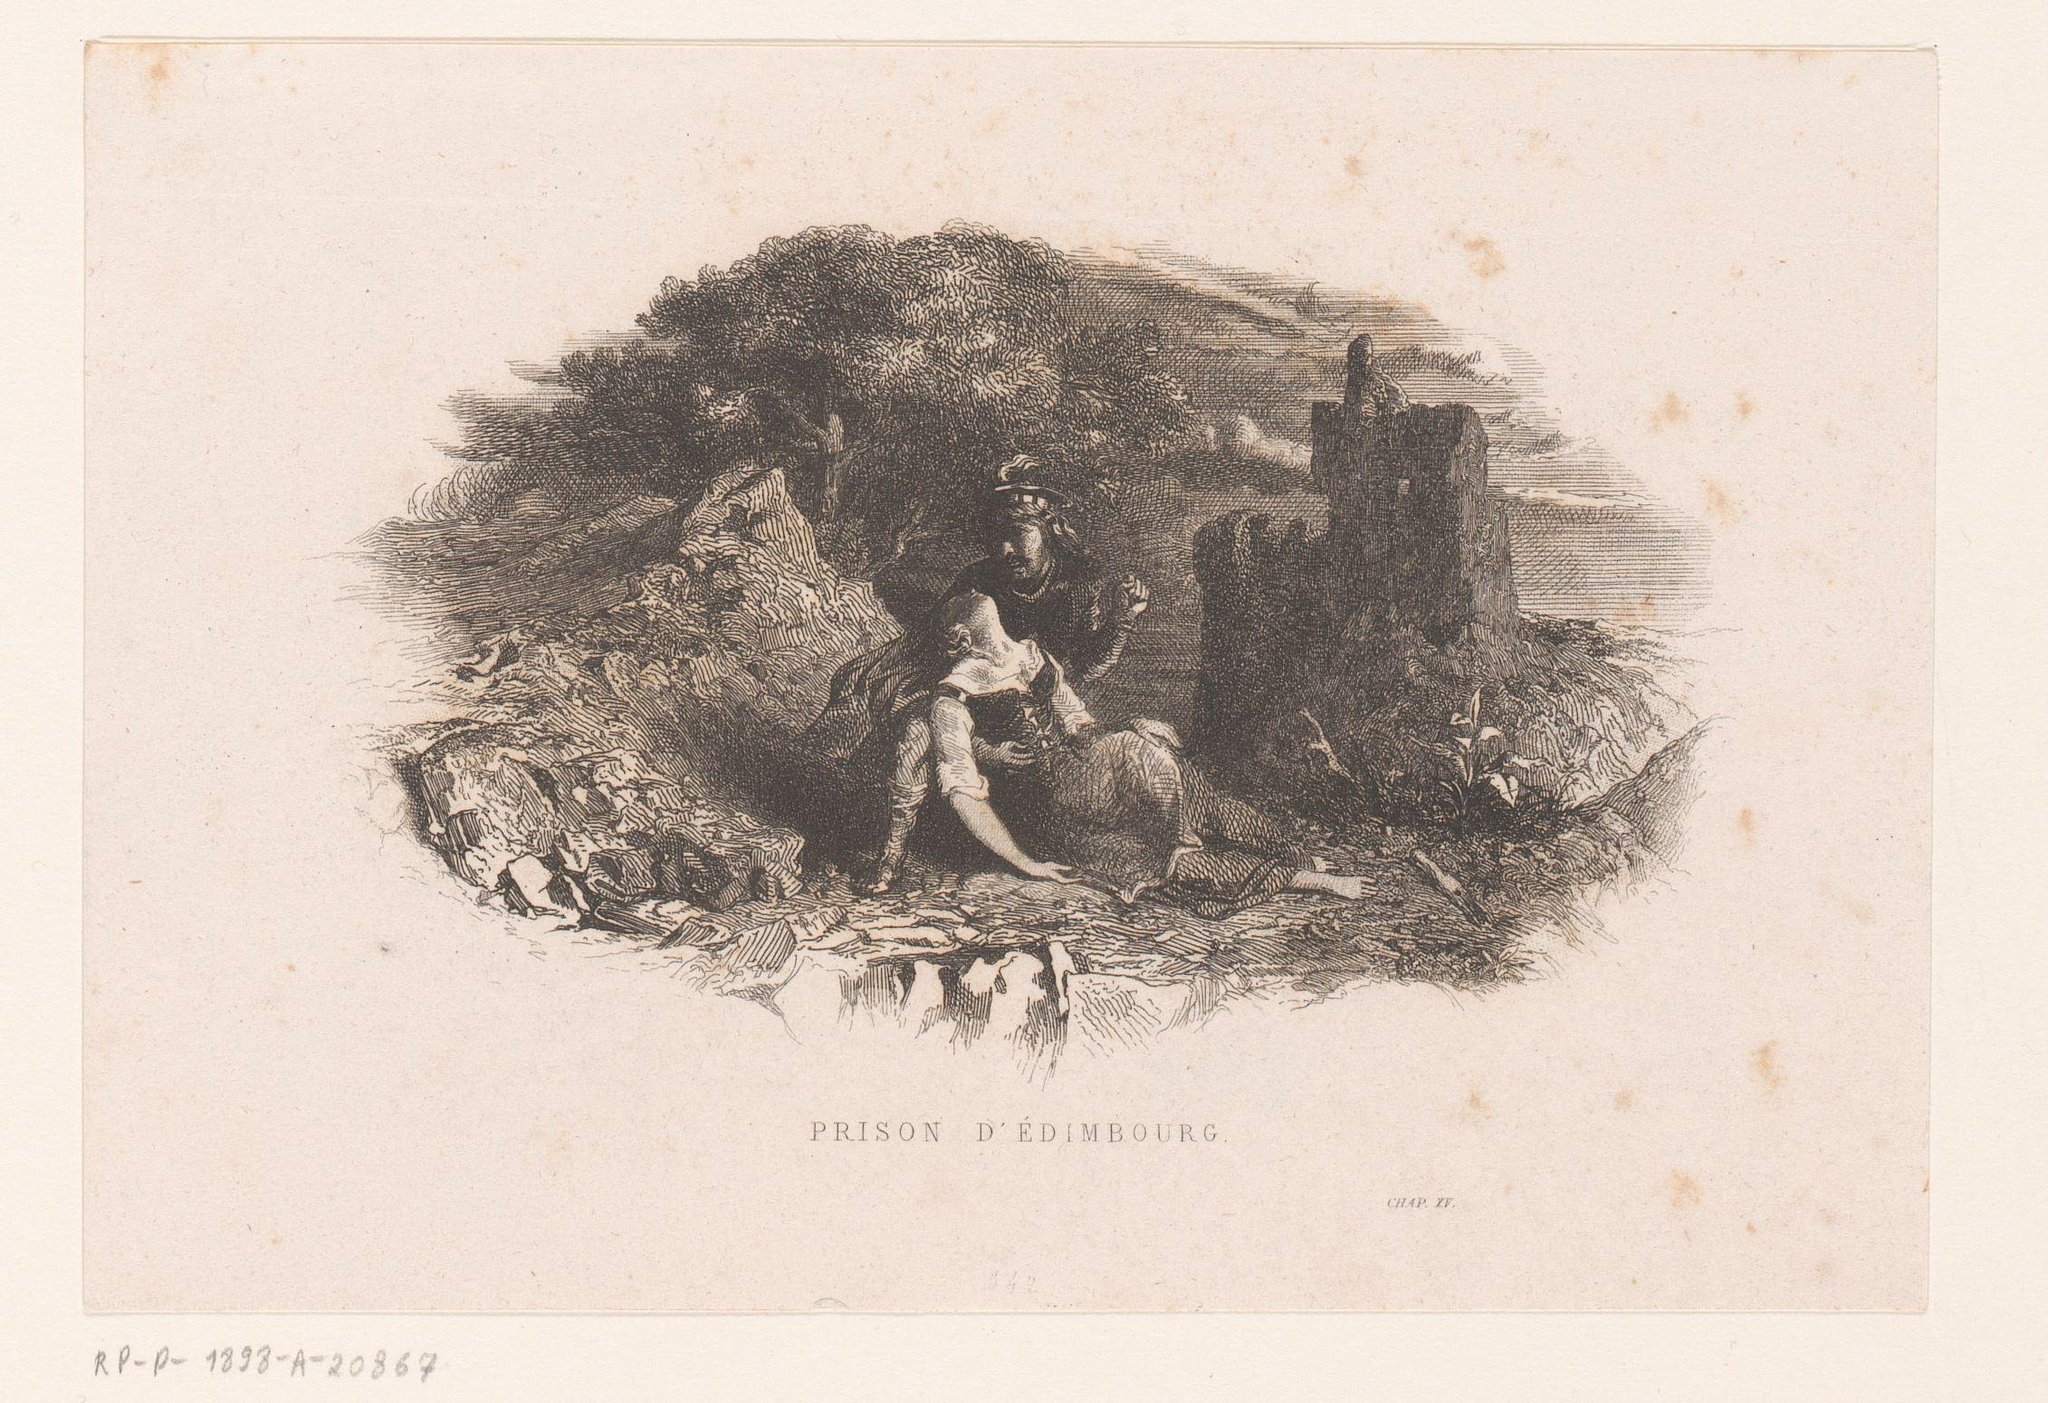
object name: book illustration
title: Prison d'Édimbourg.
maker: charles emile jacque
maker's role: draughtsman, painter, print maker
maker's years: 1813-1894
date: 1844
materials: paper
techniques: etching, roulette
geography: france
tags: prison, jail, landscape with ruins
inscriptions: collector's mark: Lugt 964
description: Prent uit: Oeuvres de Walter Scott. Parijs: Firmin-Didot, 1844.